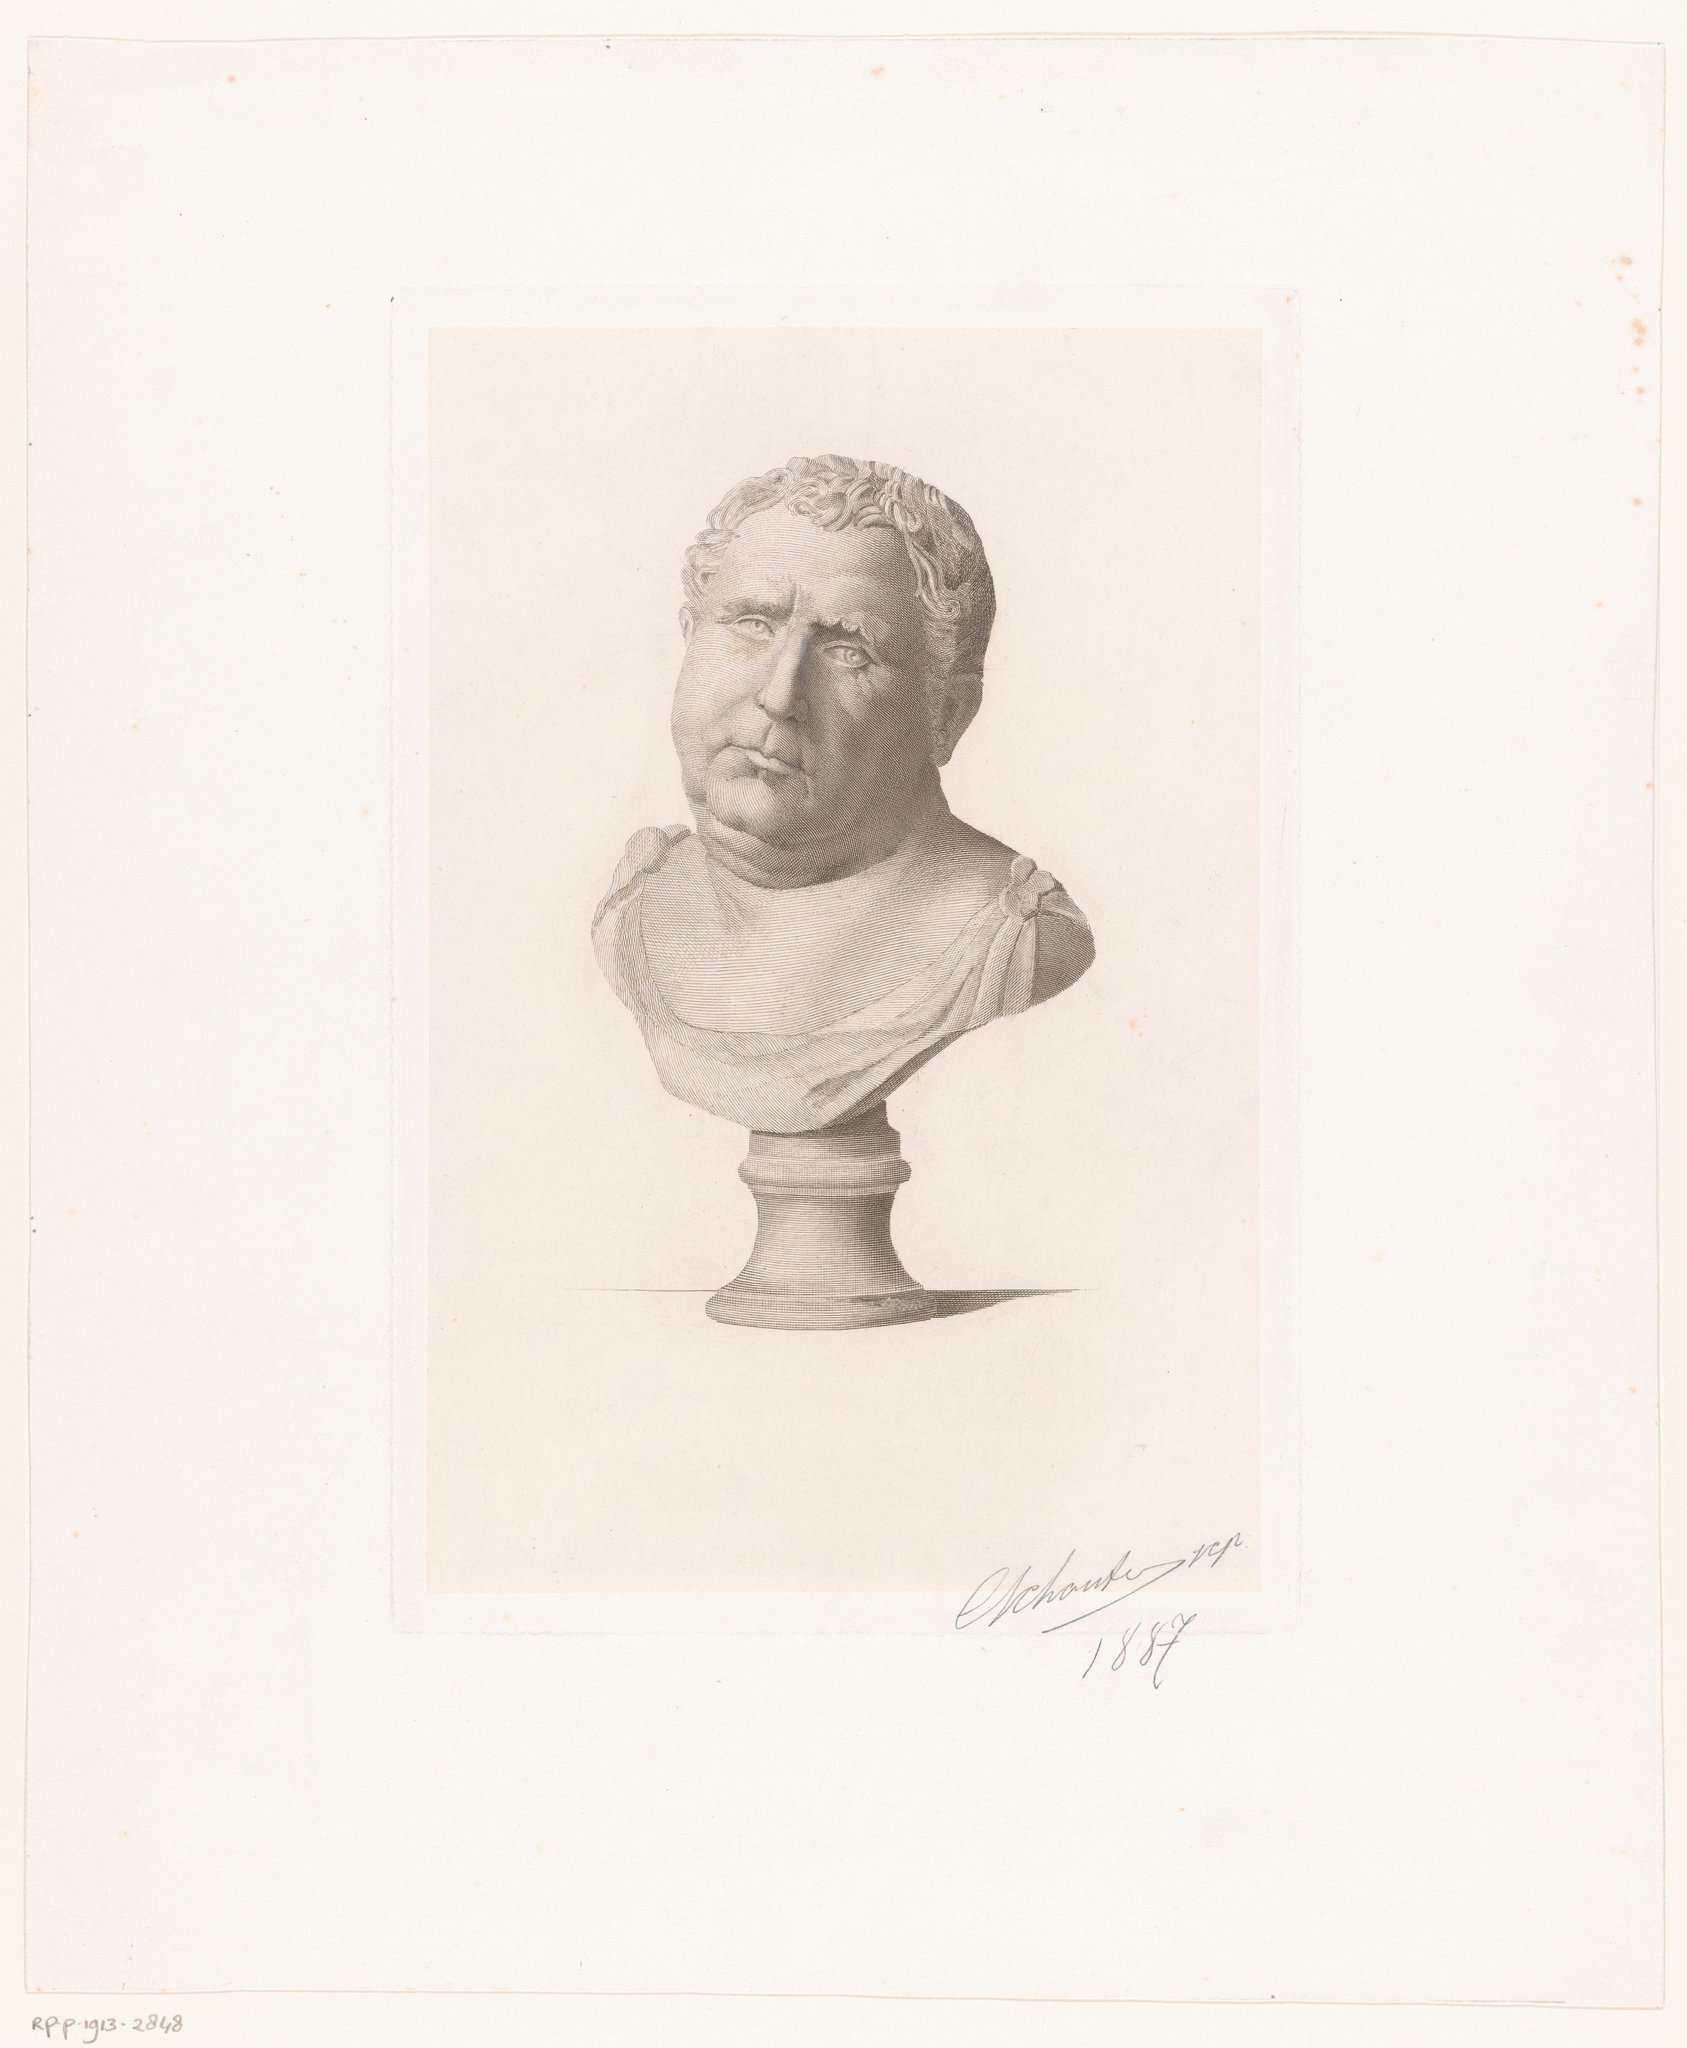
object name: print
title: Buste van keizer Vitellius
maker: c. schouten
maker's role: print maker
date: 1887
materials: paper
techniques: etching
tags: adult man, emperor, piece of sculpture, reproduction of a piece of sculpture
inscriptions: collector's mark: Lugt 2228